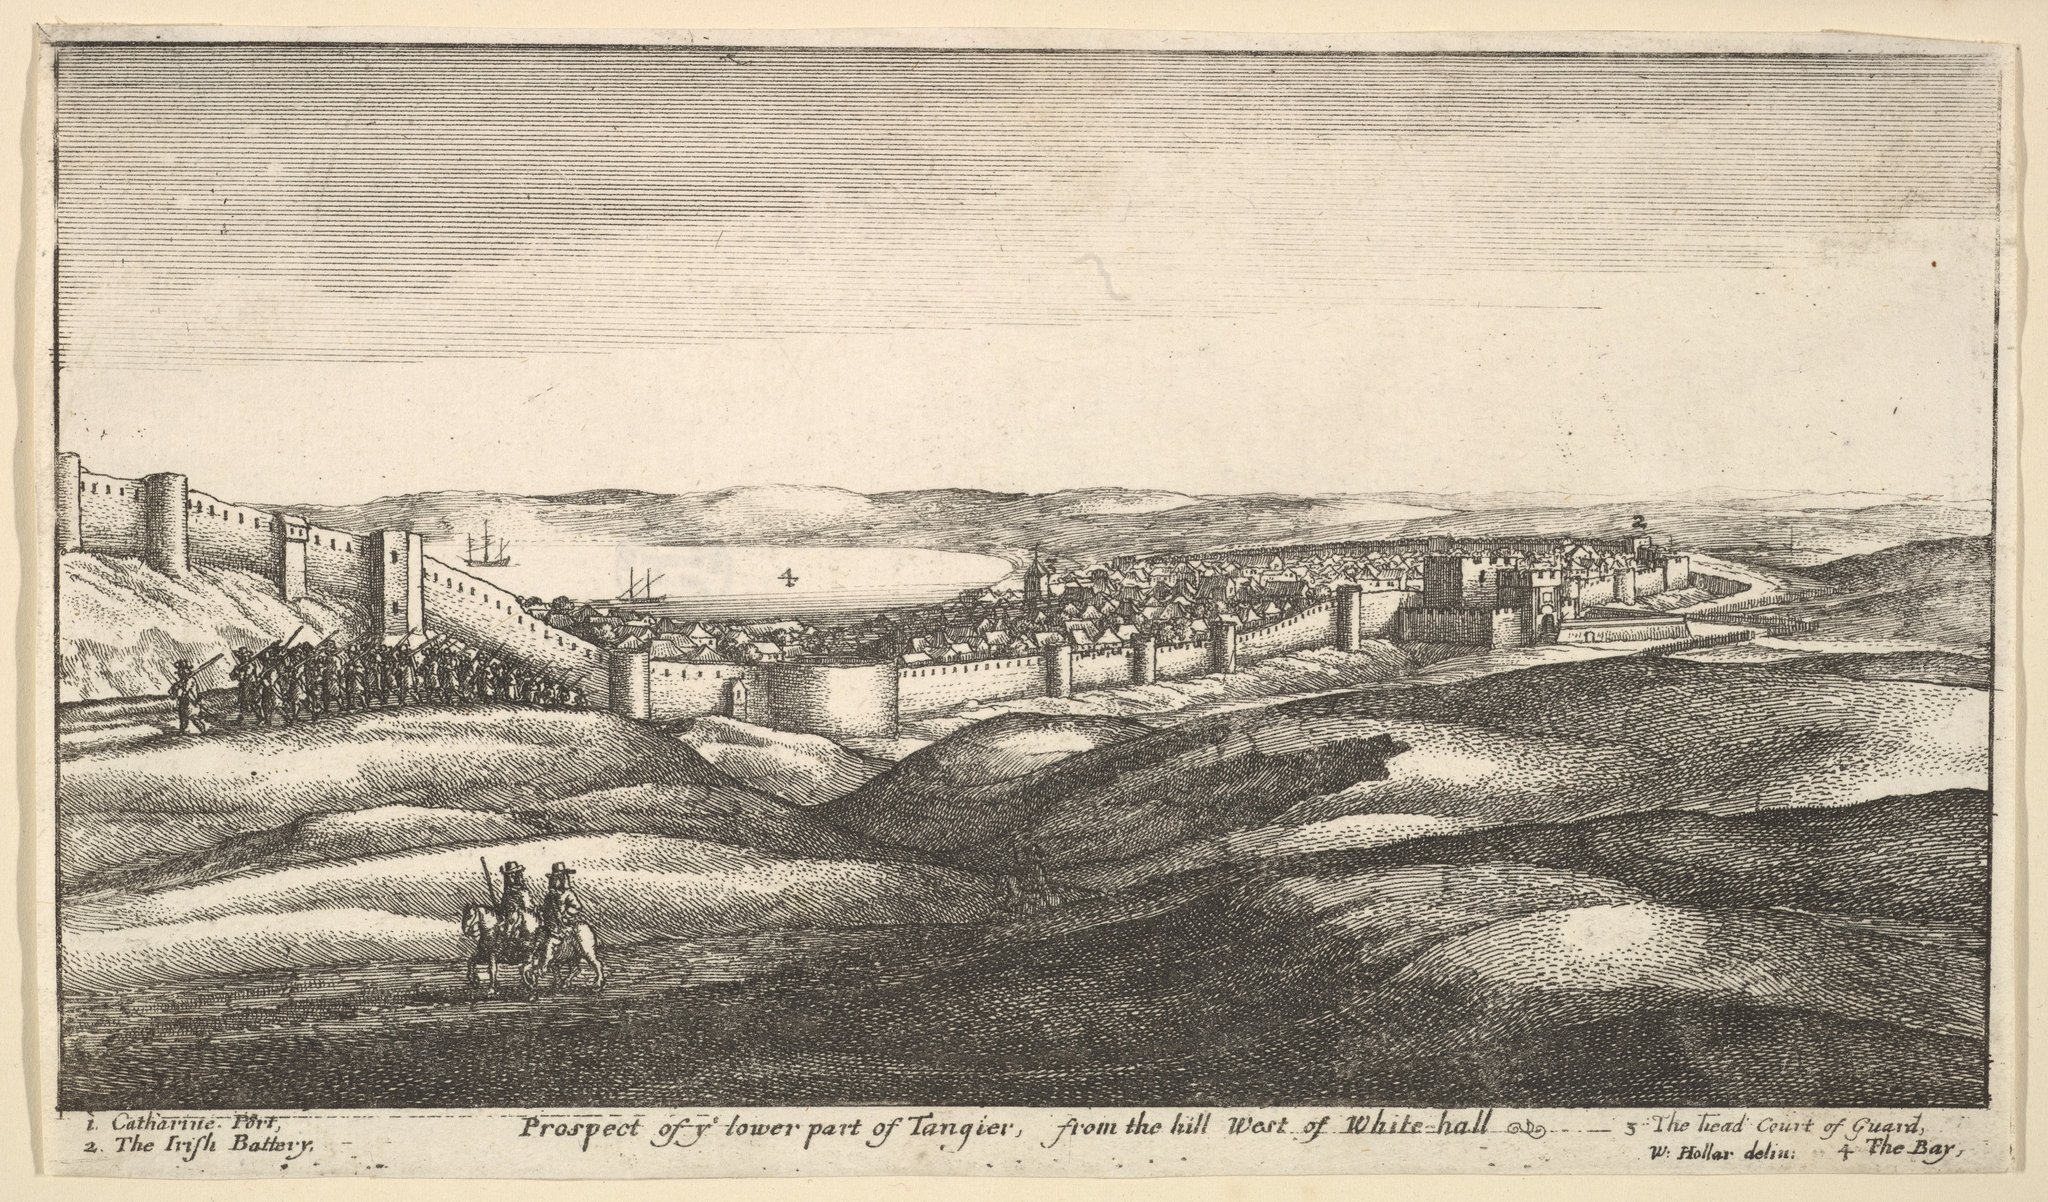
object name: print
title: Prospect of ye lower part of Tangier, from the hill West of White-hall, from "Views of Tangier"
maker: wenceslaus hollar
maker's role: artist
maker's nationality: bohemian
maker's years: 1607-1677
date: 1669-1673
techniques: etching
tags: fortification,soldiers,weapons,horses,hills